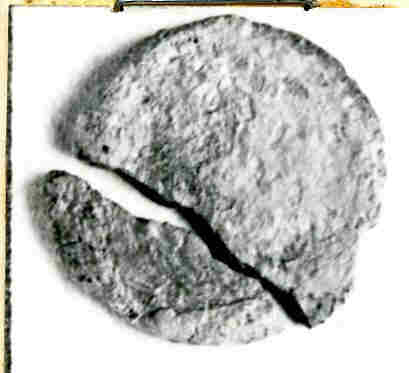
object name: coin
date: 701-900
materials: copper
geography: iran